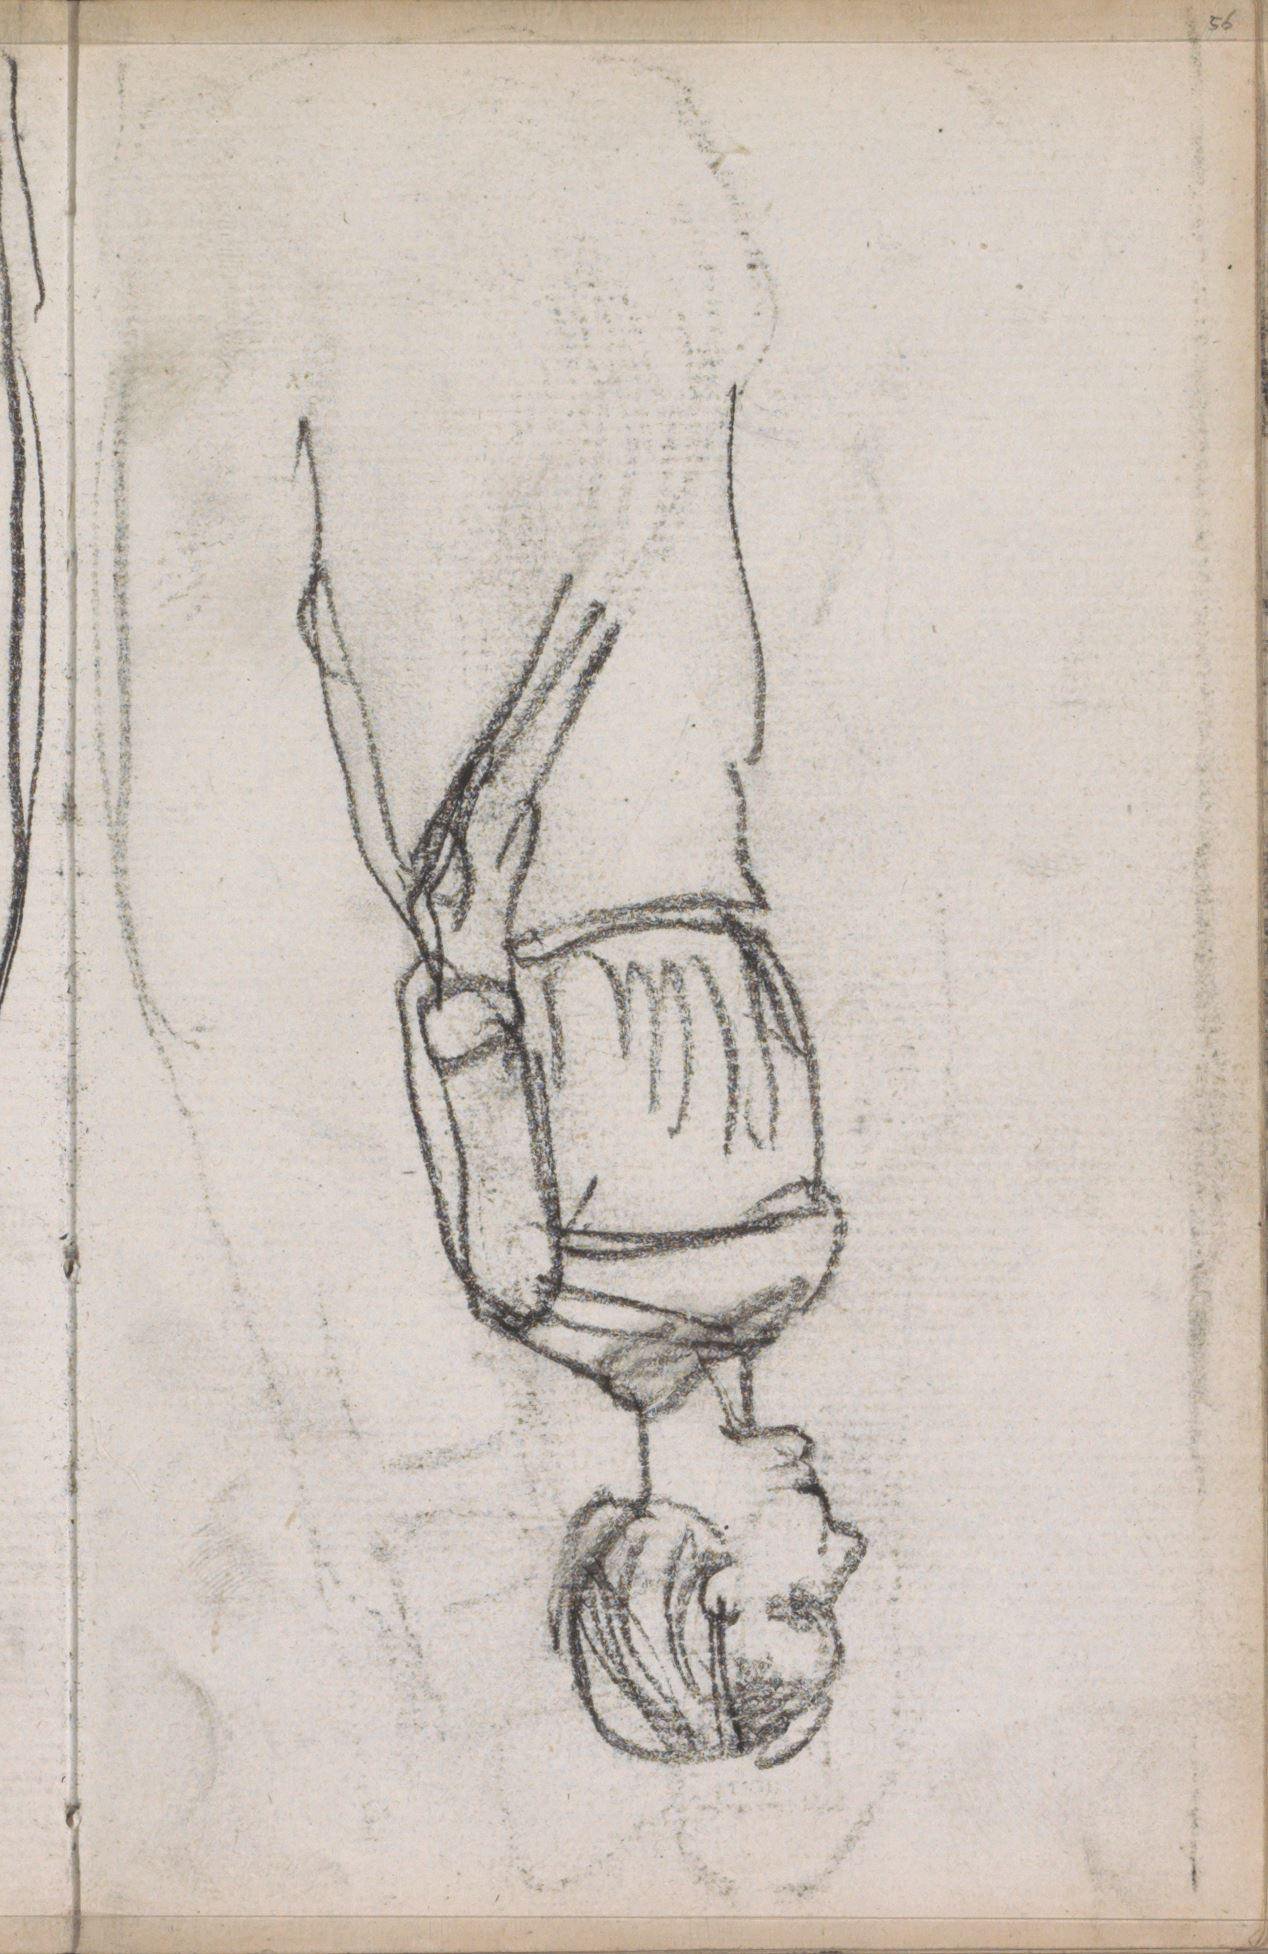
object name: sketchbook leaf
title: Staande vrouw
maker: george hendrik breitner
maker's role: draughtsman, painter, print maker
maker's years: 1857-1923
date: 1884-1886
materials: chalk, paper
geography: drenthe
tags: adult woman, standing figure - aa - female human figure (+ sideview, profile)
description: Pagina 56 uit een schetsboek met 67 bladen vervaardigd in Drenthe.